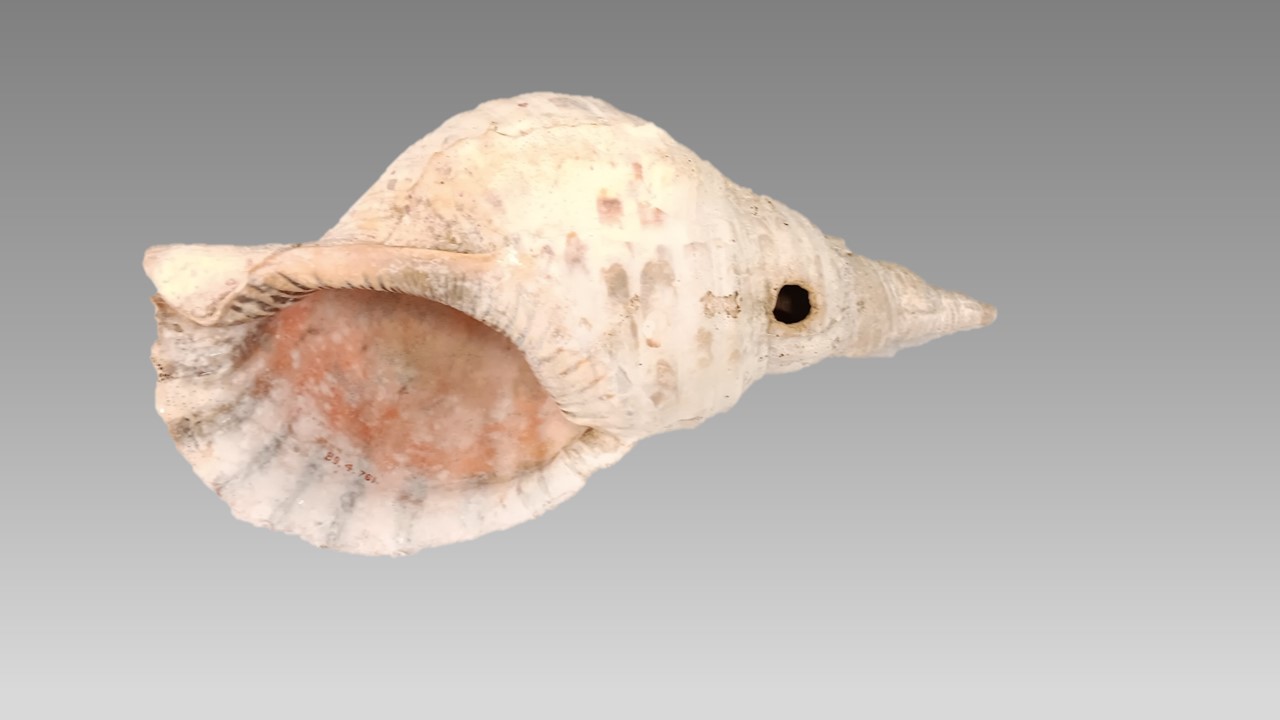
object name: conch shell trumpet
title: Pū (Conch Shell Trumpet)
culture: melanesian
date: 1867-1900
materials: shell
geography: solomon islands